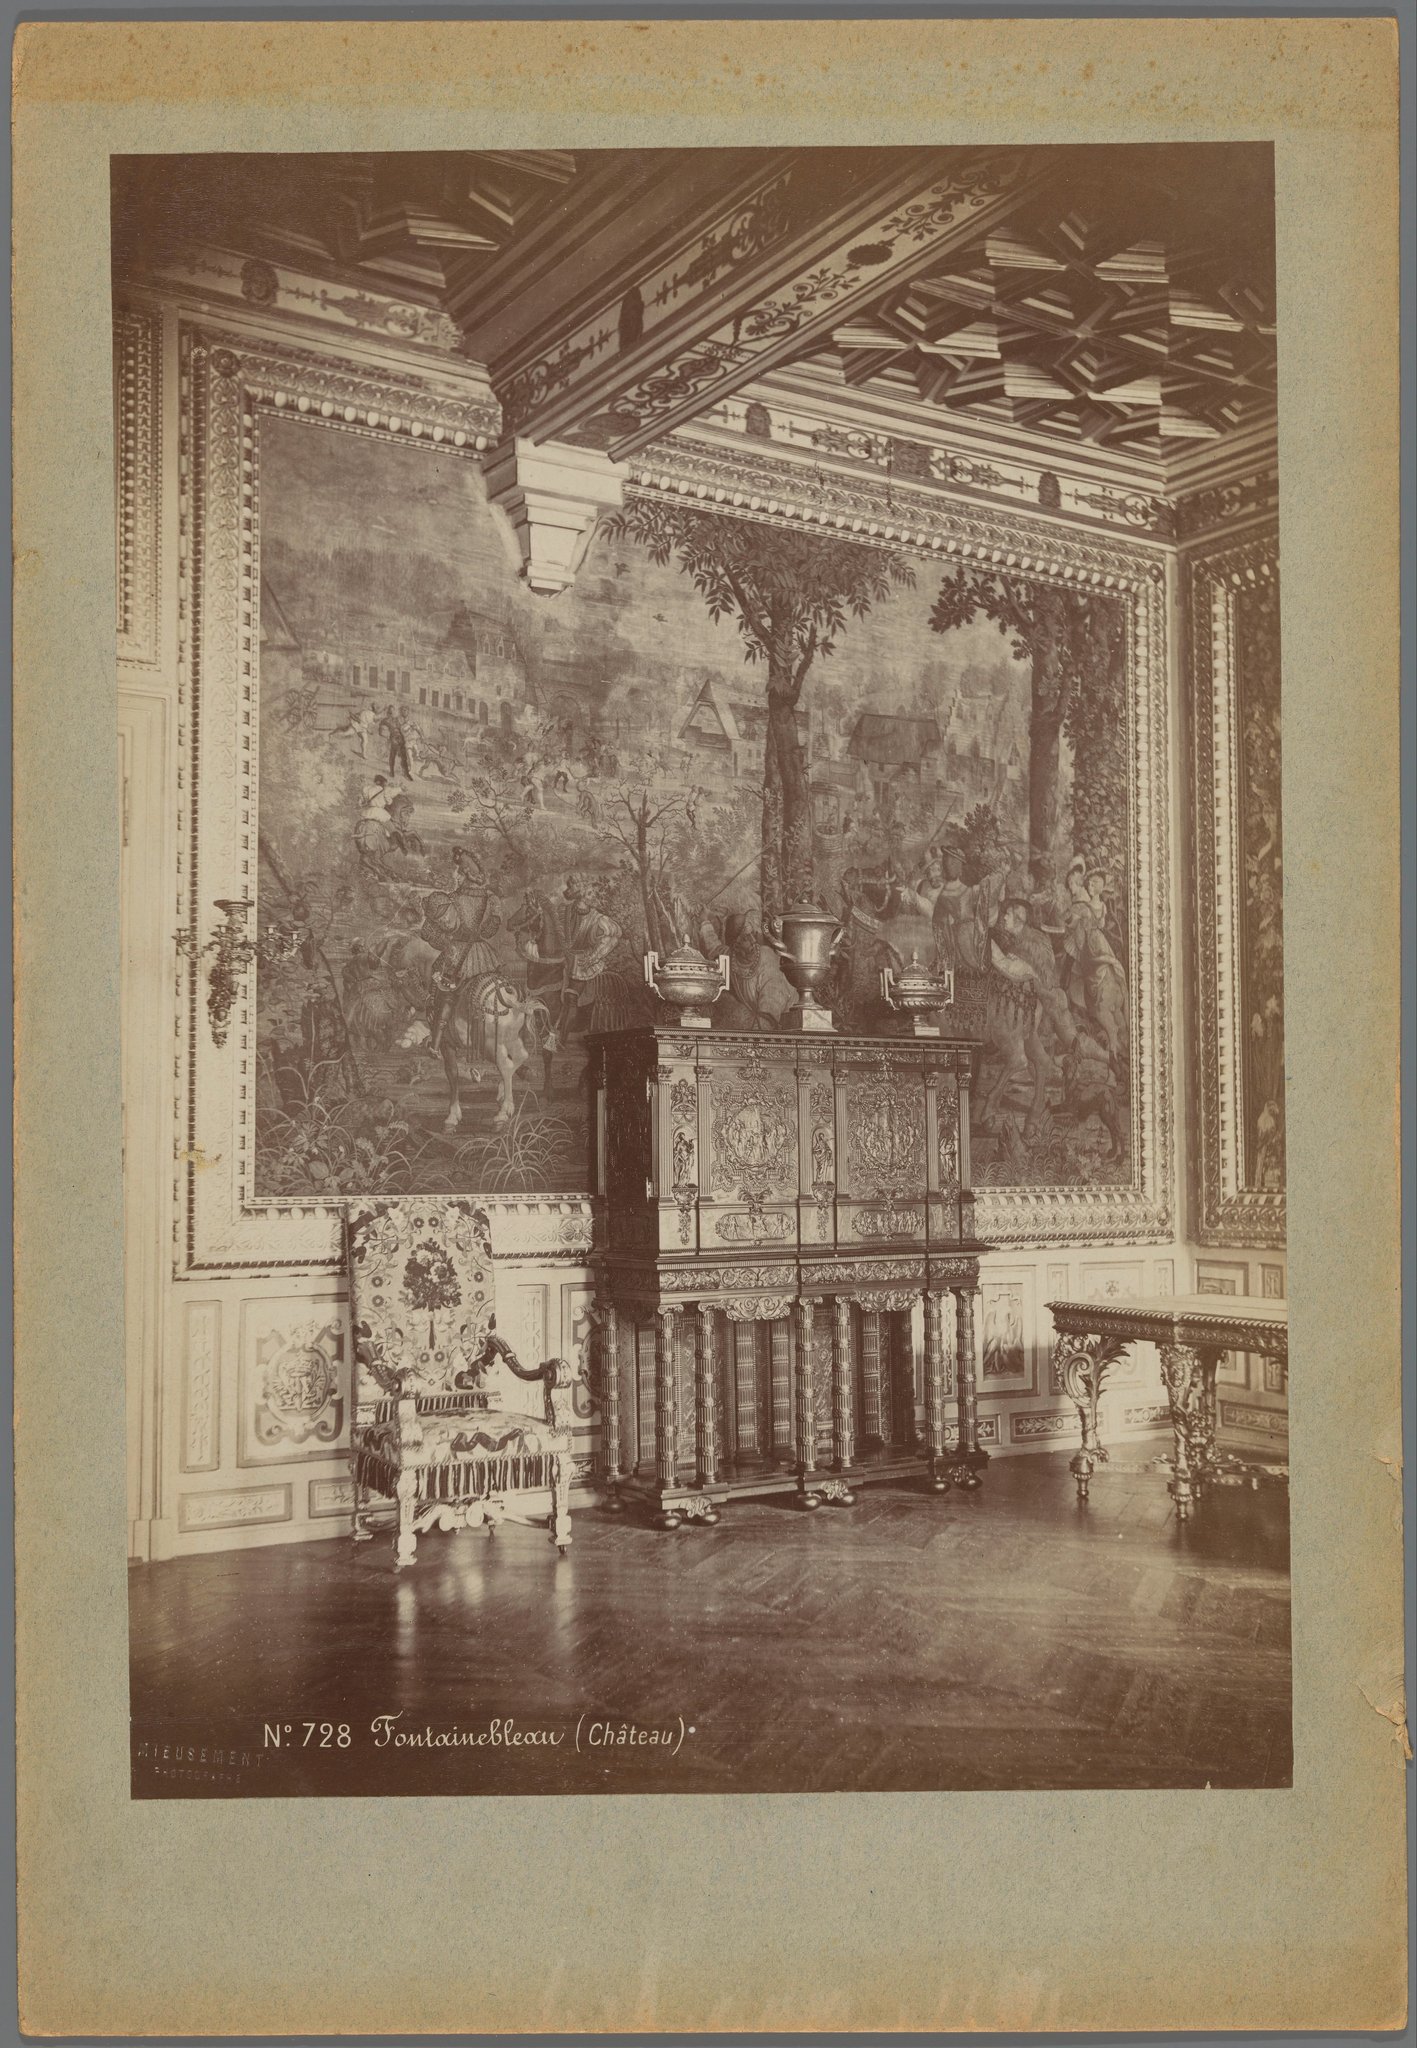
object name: photograph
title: Interieur van het Paleis van Fontainebleau met een wandkast en een stoel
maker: séraphin-médéric mieusement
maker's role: fotograaf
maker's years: 1840-1905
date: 1875-1900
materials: cardboard, photographic support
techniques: albumen print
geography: fontainebleau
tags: palace, interior ~ representation of a building, chair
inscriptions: number: ‘No. 728’, name: ‘MIEUSEMENT PHOTOGRAPHE’, collector's mark: Lugt 3937, inscription: ‘MONUMENTS HISTORIQUES’, name: ‘KUNSTBOEKHANDEL J. A. G. DE LEUR PHOTOGRAAF - UITGEVER HUIGENSPARK, 40b. DEN HAAG.’